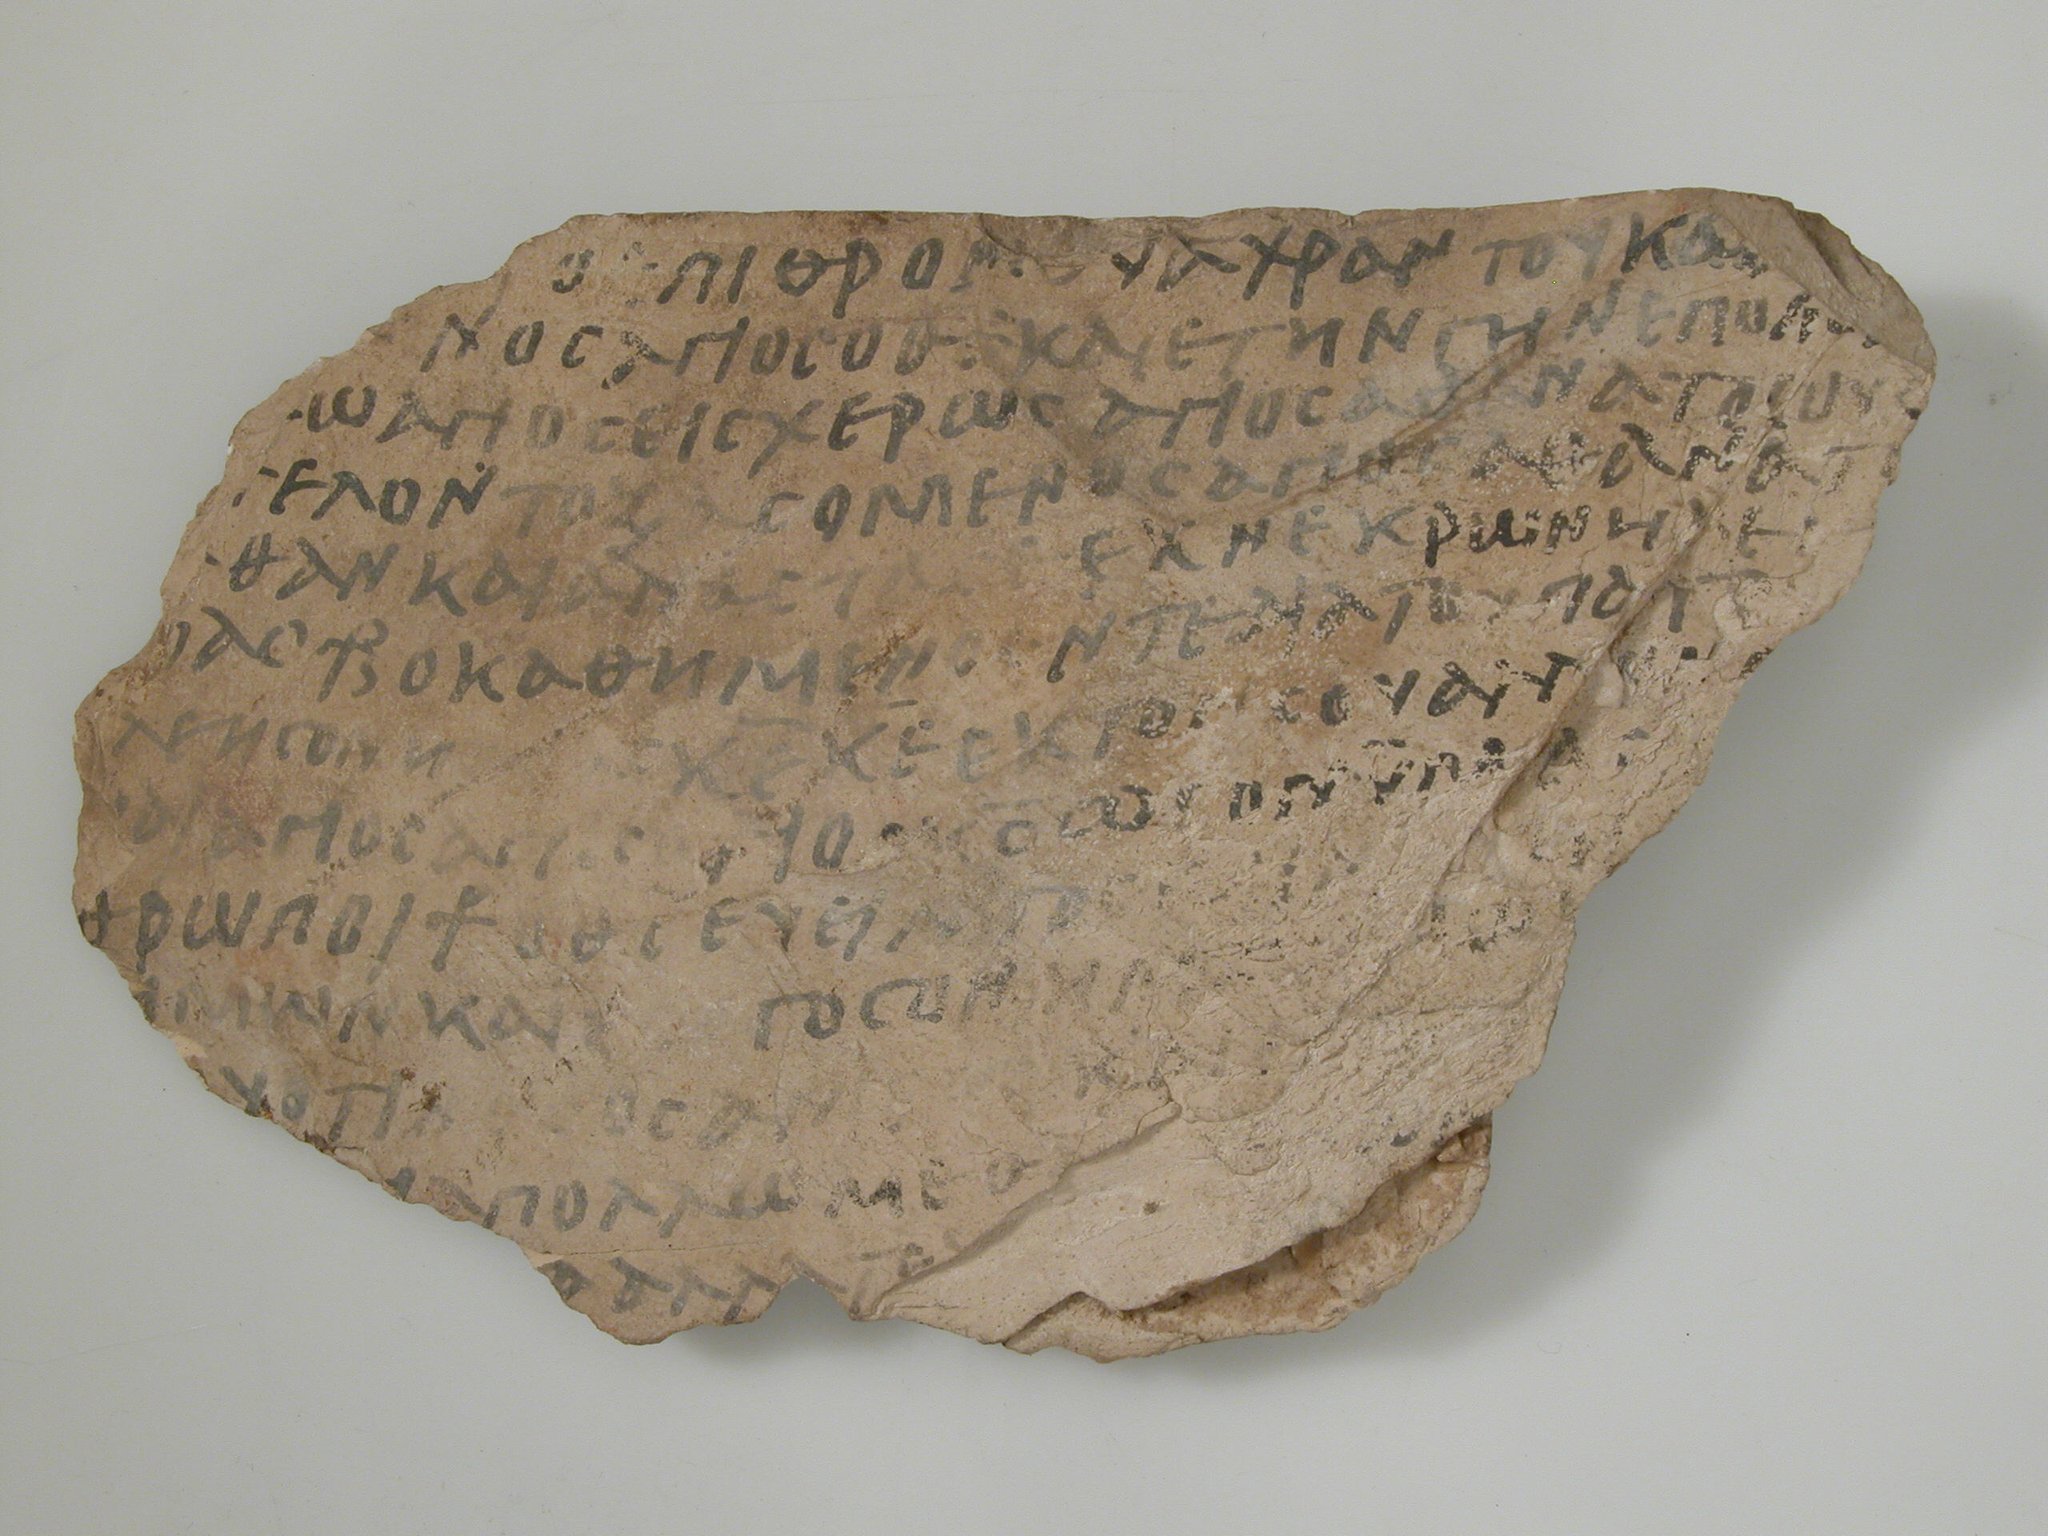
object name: ostrakon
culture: coptic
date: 601-700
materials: ink, limestone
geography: egypt